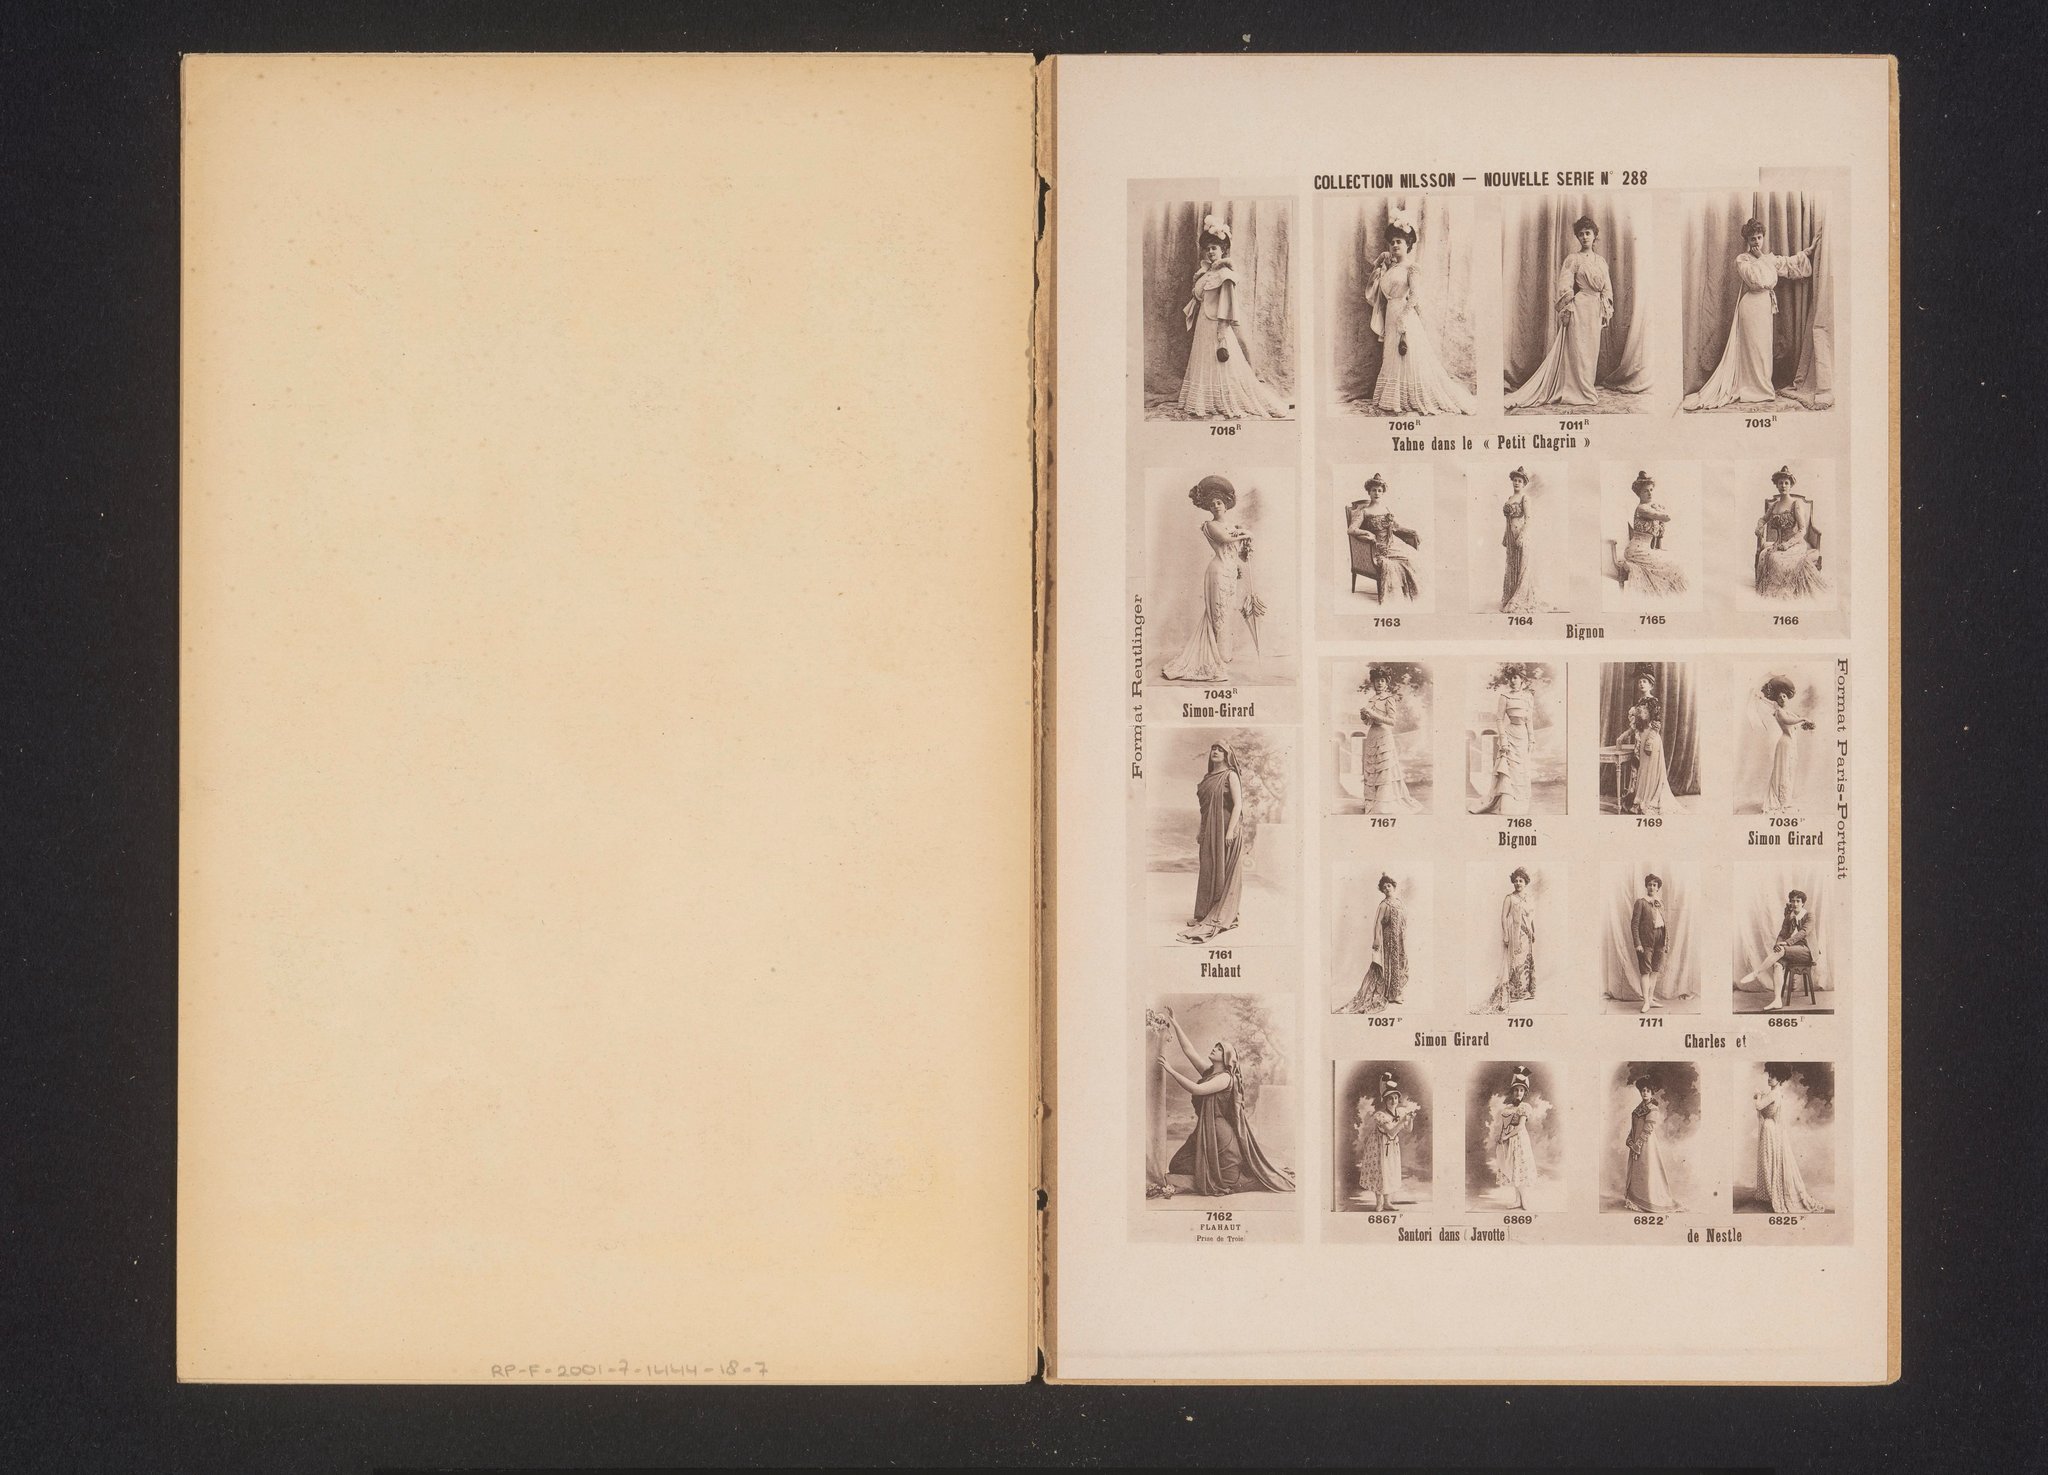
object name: page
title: 25 portretten van Léonie Yahne, Juliette Simon-Girard en anderen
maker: Anonymous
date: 1895-1900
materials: paper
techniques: photograph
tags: historical persons - bb - woman, historical persons, portrait of actor, actress, portrait of opera-singer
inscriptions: inscription: ‘Format Reutinger/ Yahne dans le << Petit Chagrin >>/ Bignon/ Simon-Girard/ Bignon Simon Girard/ Flahaut/ Simon Girard Charles et/ Santori dans Javotte de Nestle/ Flahaut/ Prise de Troie/ Format Paris - Portrait’, number: ‘No 288’